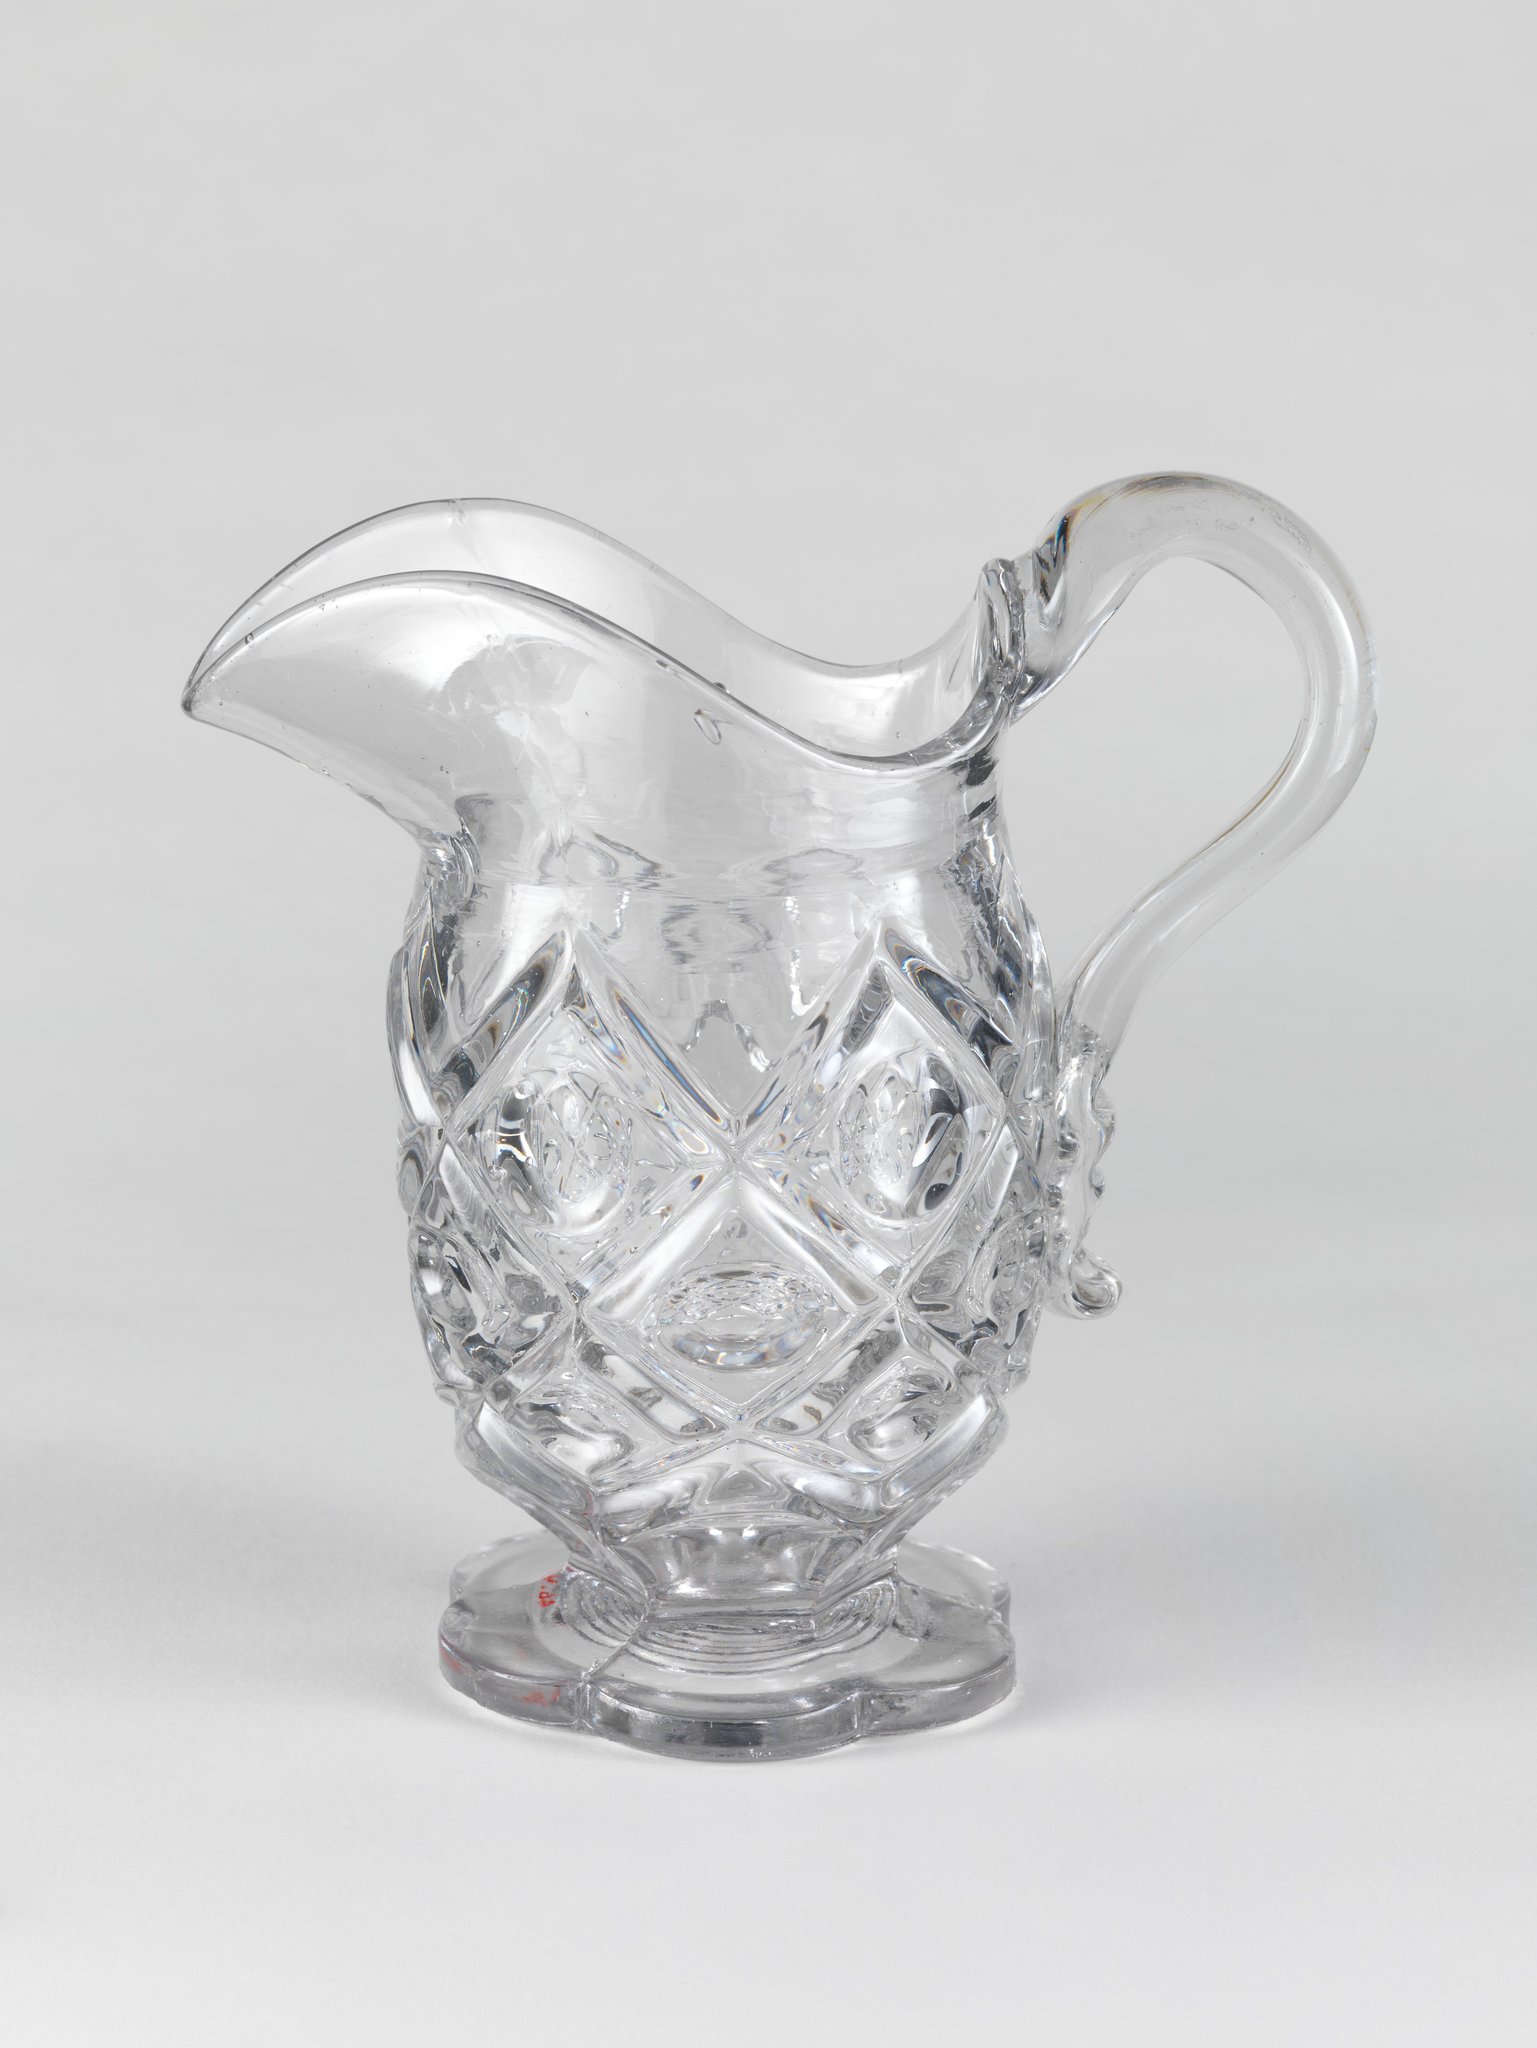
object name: pitcher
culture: american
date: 1850-1870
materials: diamond, glass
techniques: pressed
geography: united states